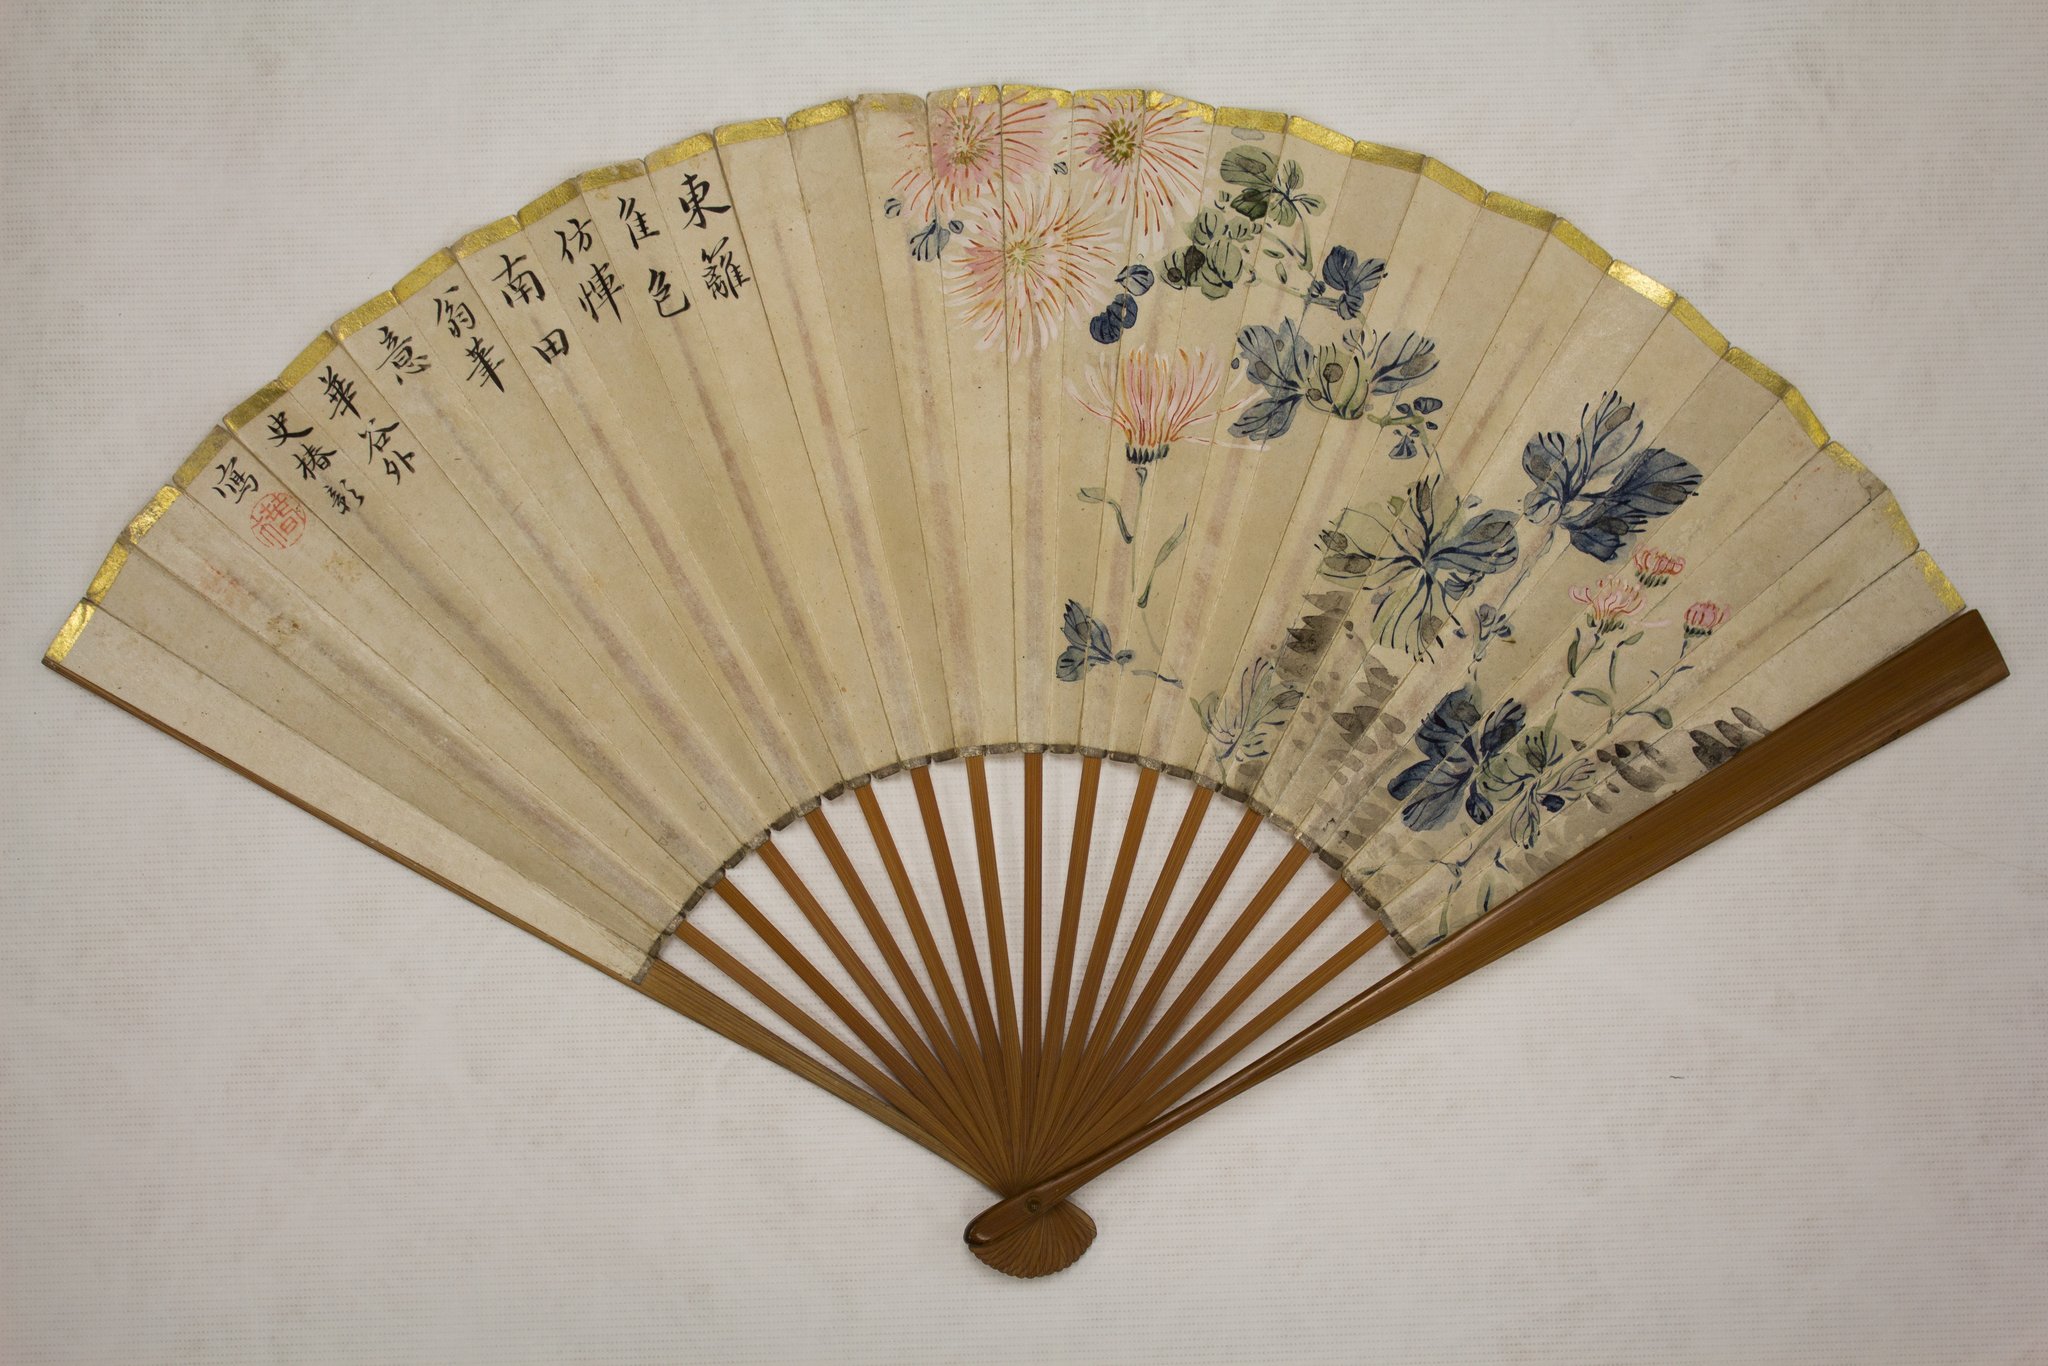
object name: folding fan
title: Chrysanthemums at the Eastern Fence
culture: japanese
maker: tsubaki kakoku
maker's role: artist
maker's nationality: japanese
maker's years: 1825-1850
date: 1840-1849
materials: ink, paper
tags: flowers